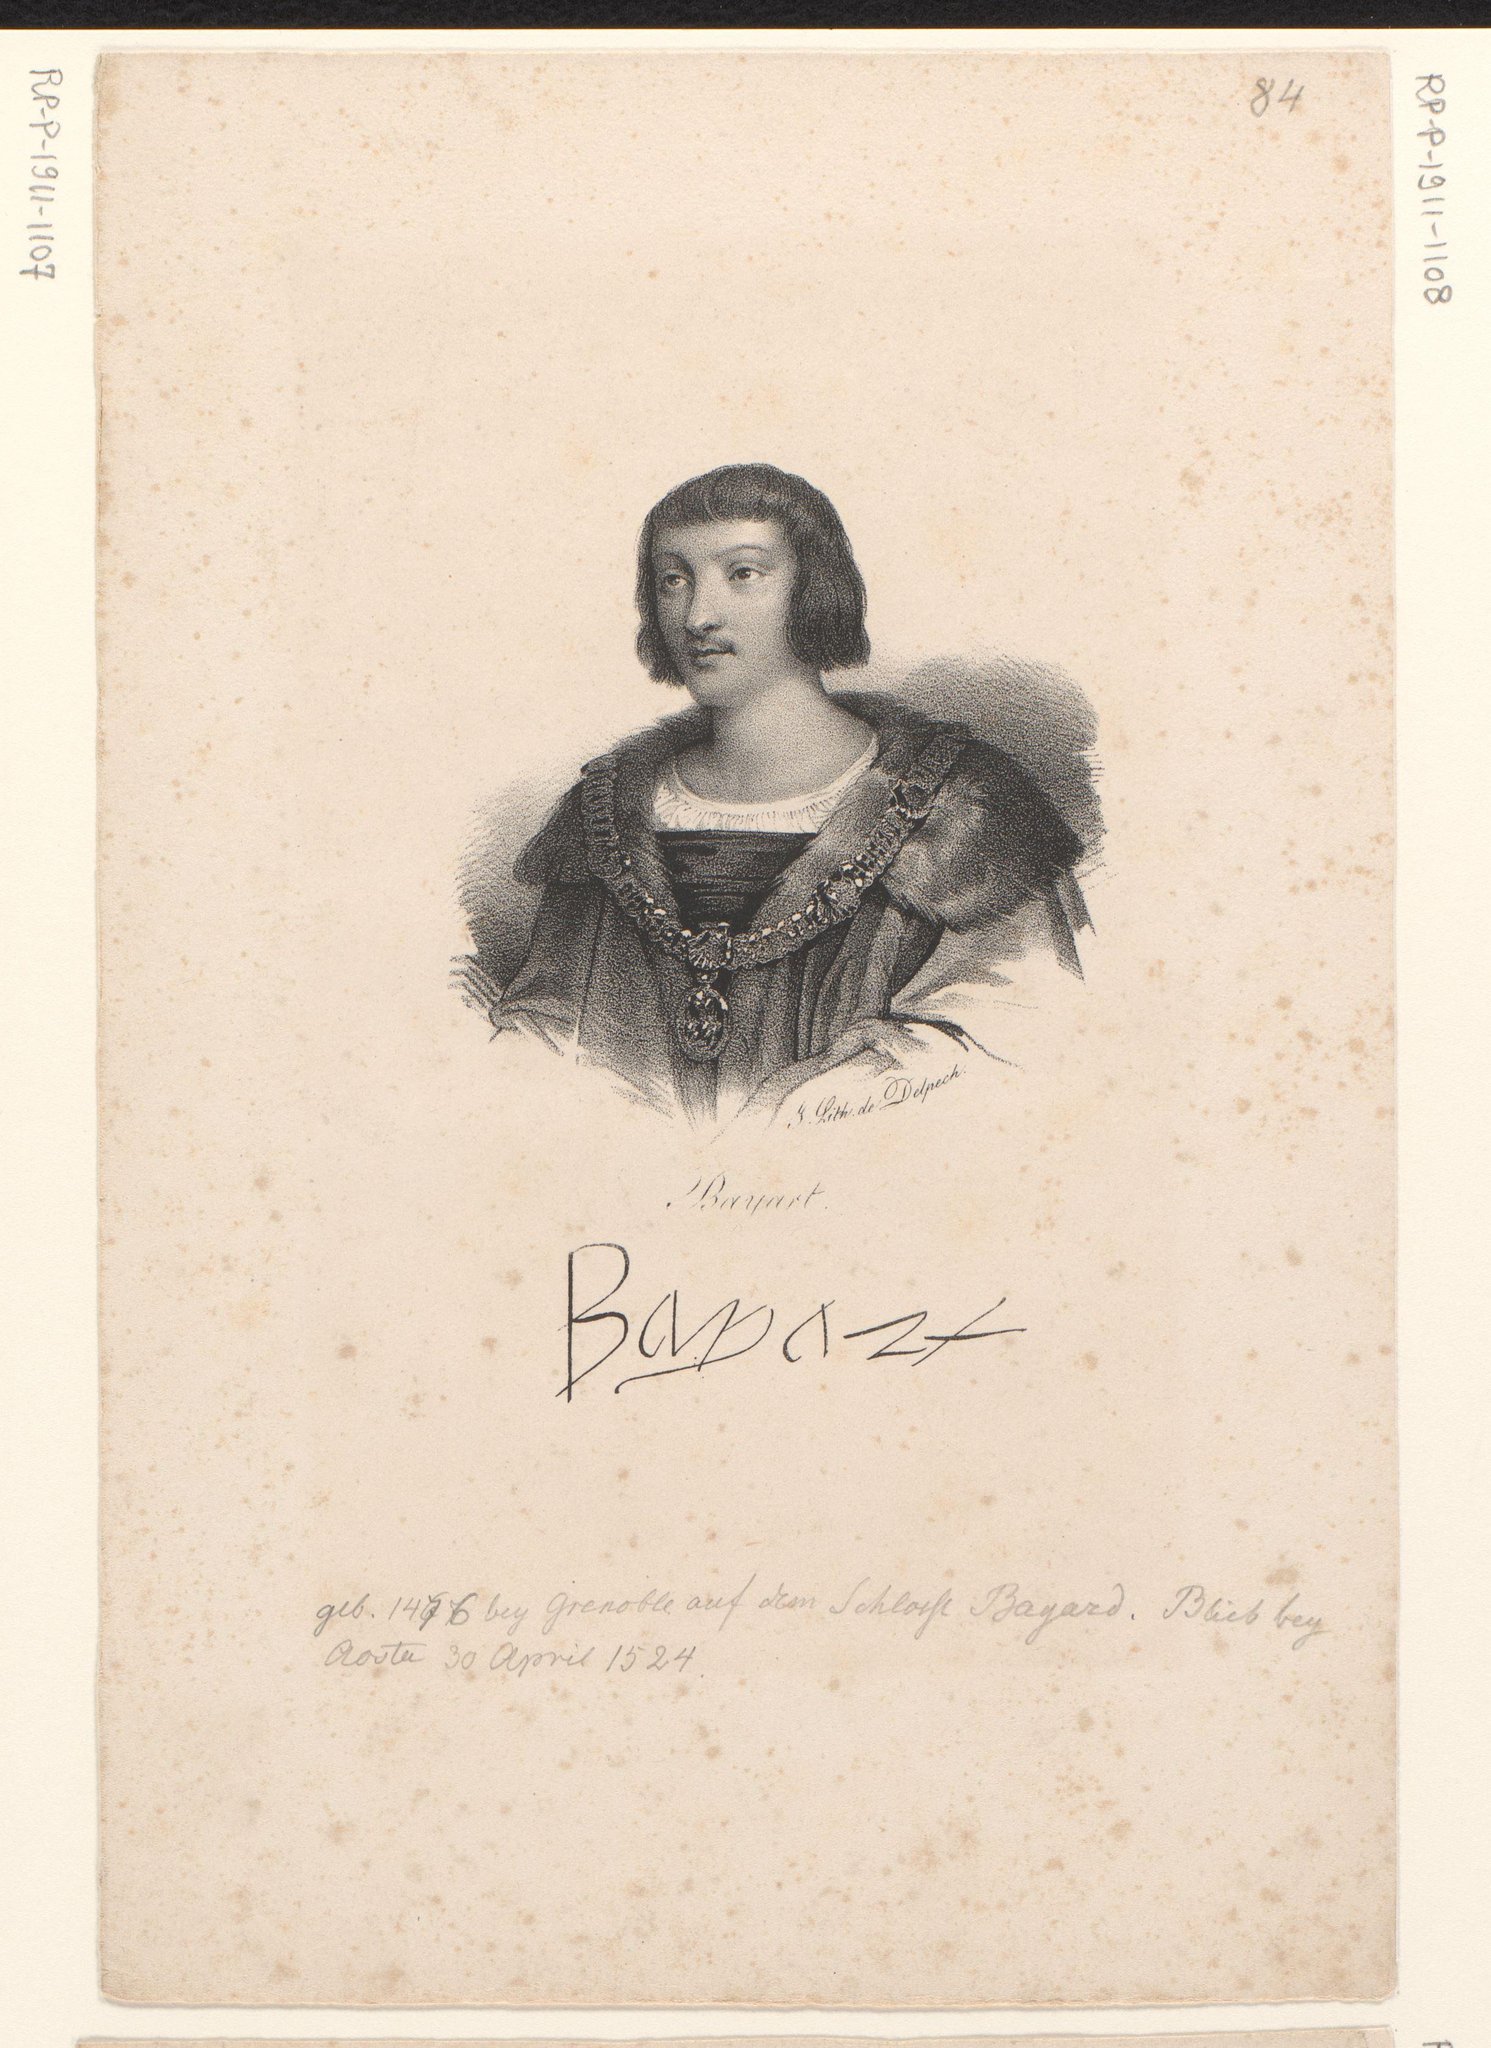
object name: print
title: Portret van Pierre Terrail de Bayard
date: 1818-1842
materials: paper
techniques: lithograph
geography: paris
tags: pierre du terrail de bayard, historical persons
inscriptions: collector's mark: Lugt 2228a